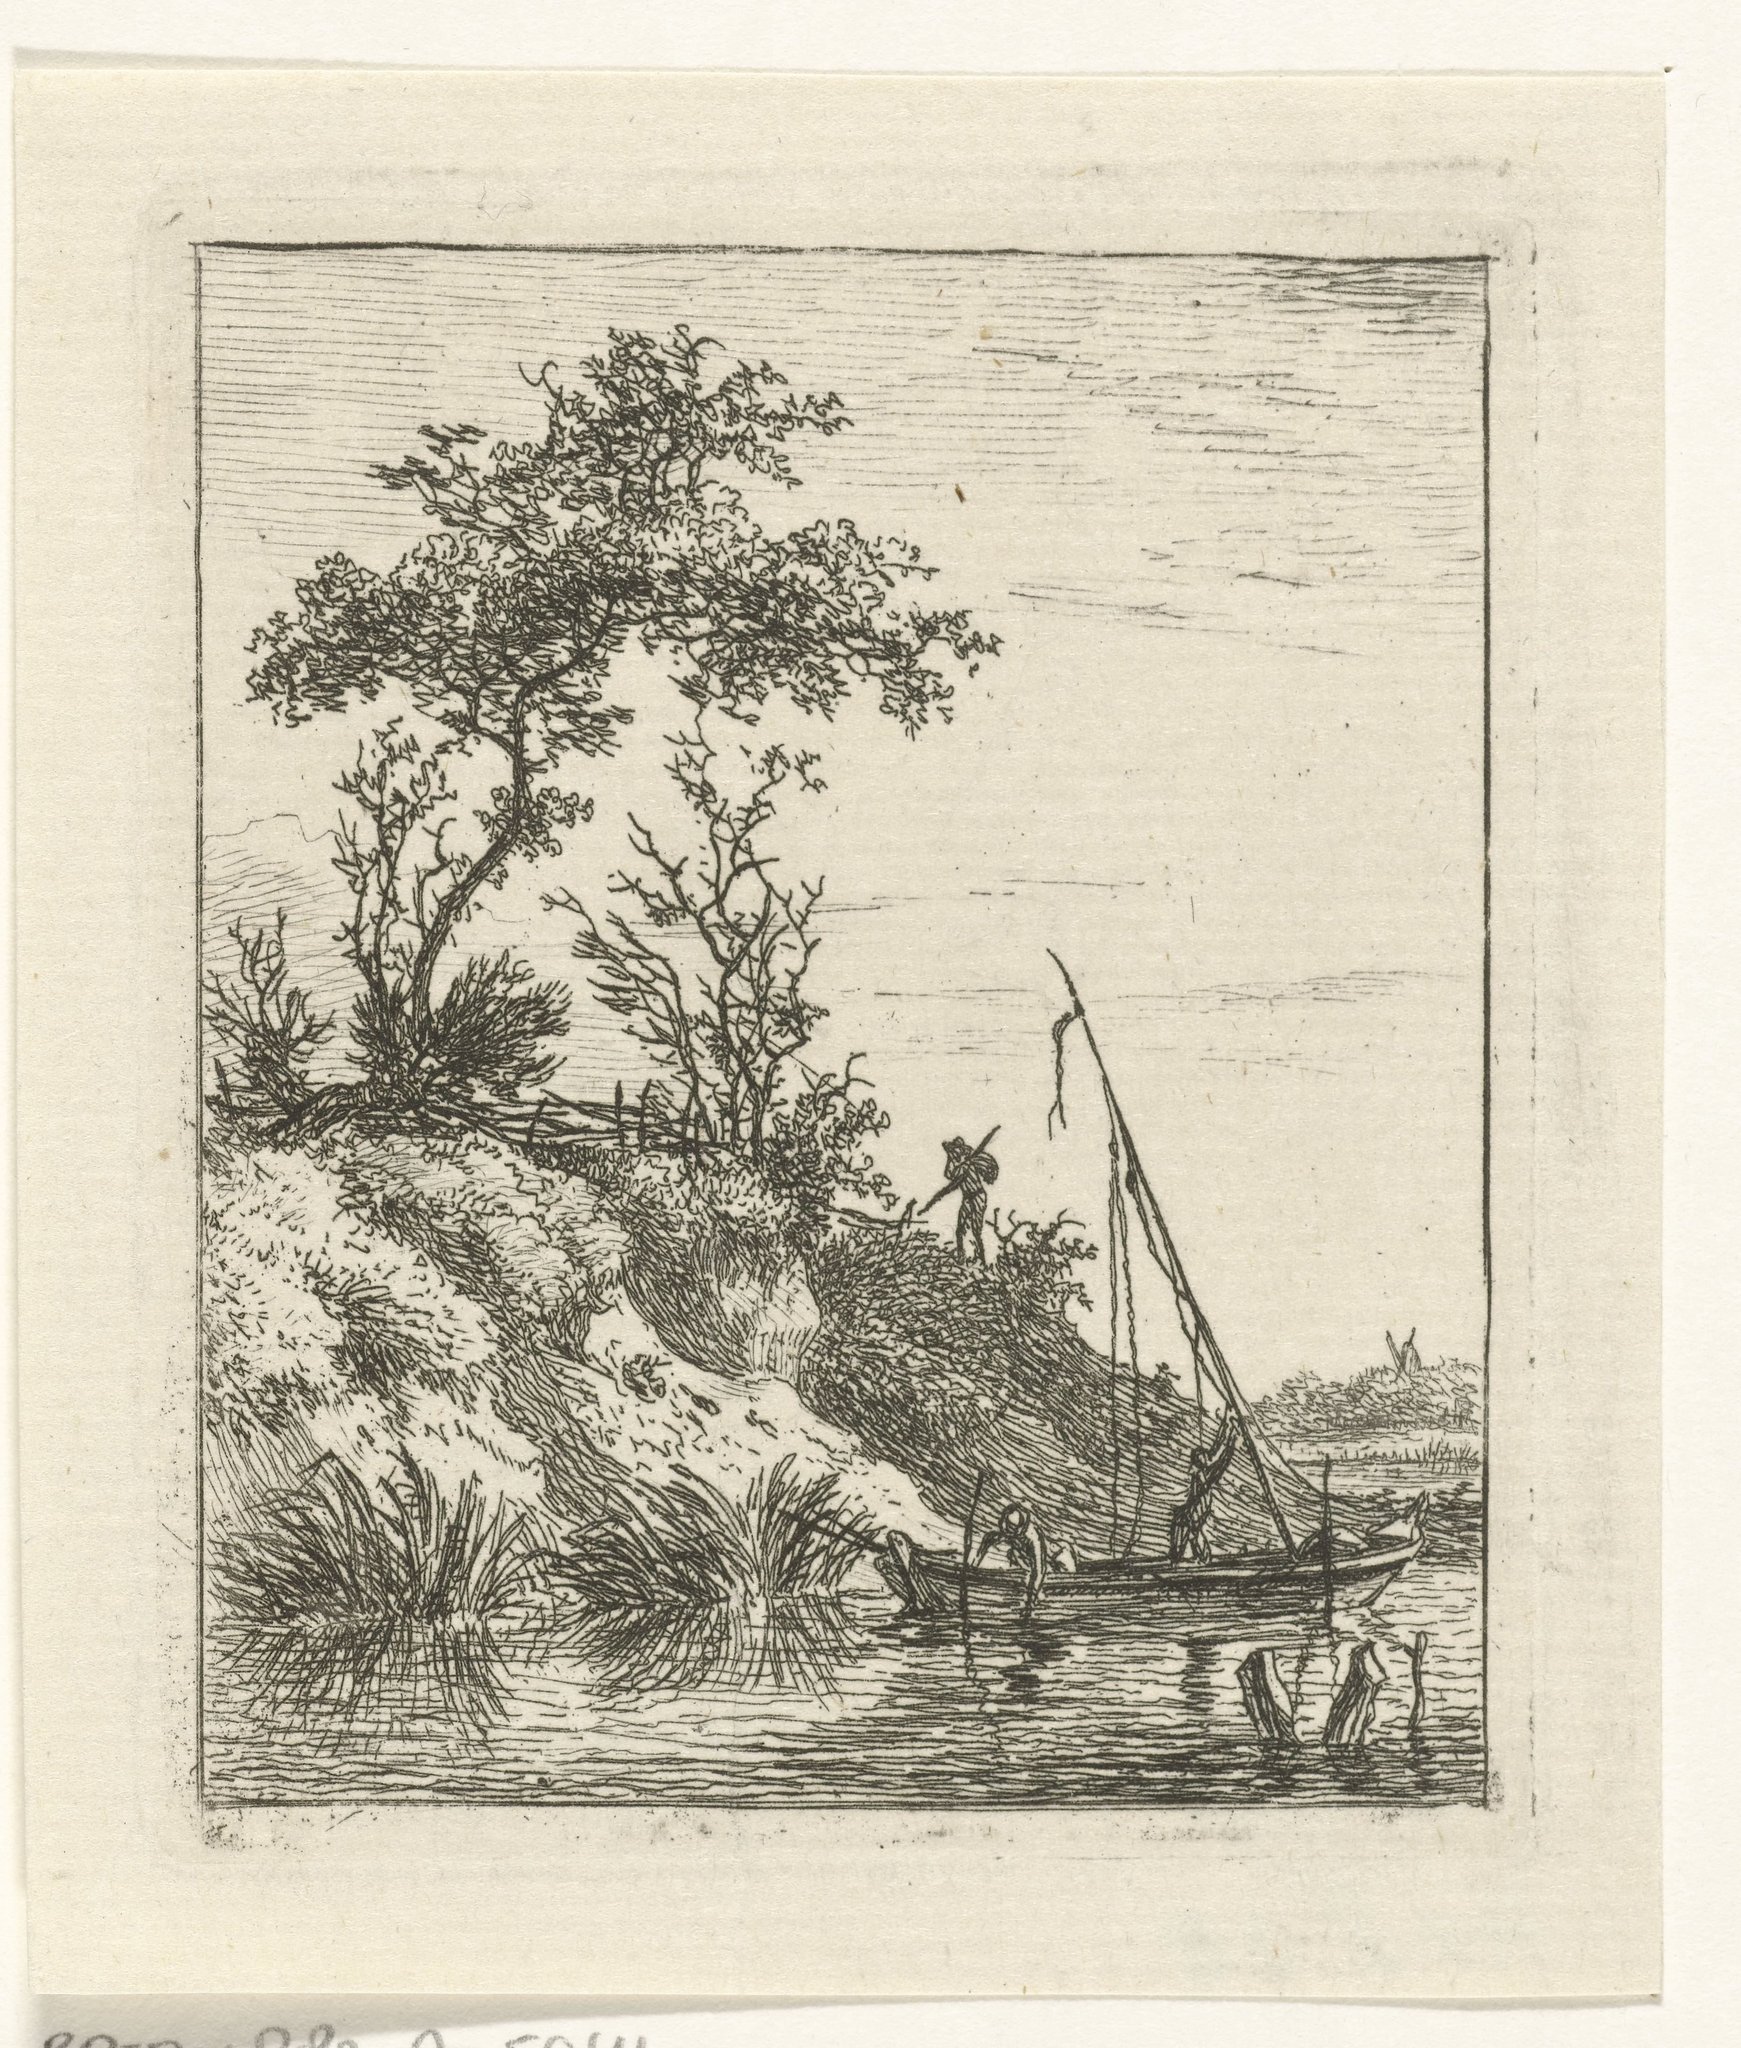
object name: print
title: Omhoog zetten van de mast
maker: hermanus fock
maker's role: conservator, draughtsman, painter, print maker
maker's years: 1766-1822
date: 1781-1822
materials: paper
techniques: etching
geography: amsterdam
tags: sailing-ship, sailing-boat (+ preparations ~ departure)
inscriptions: collector's mark: Lugt 2228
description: Een gezicht op een boot met twee personen, waarvan er één de mast omhoog zet. Op de hoge oever loopt een man met een knapzak.